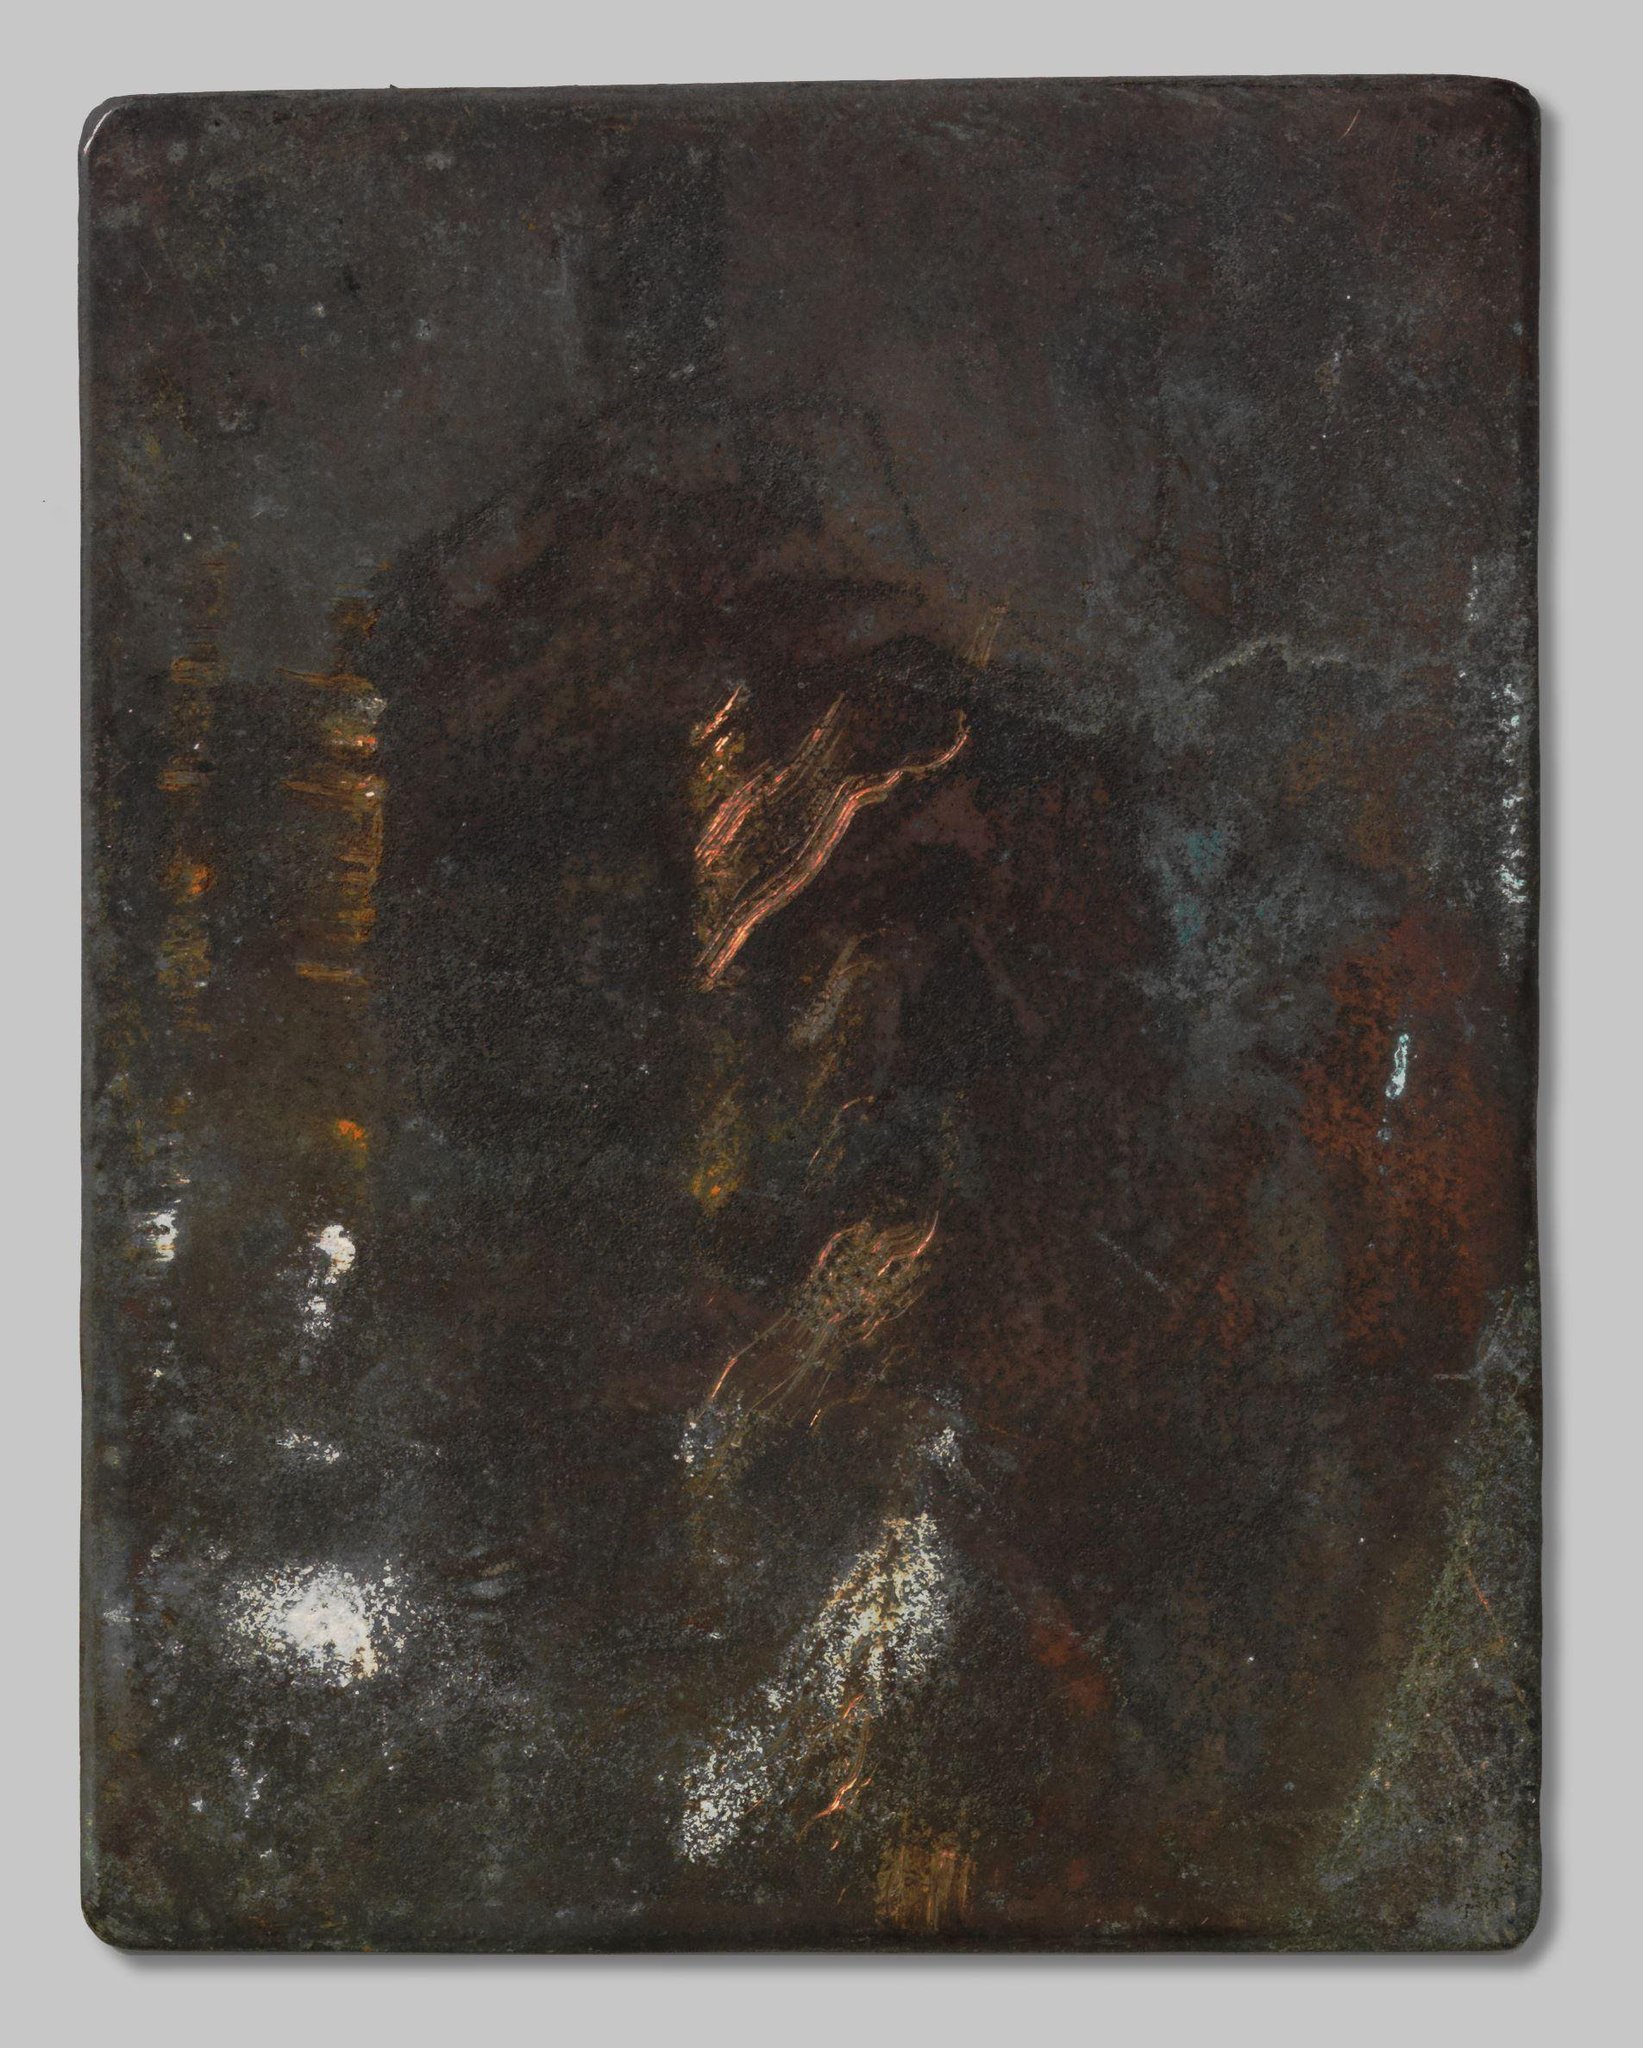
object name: copper plate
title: Boerenjongen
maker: willem witsen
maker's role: draughtsman, painter, print maker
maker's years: 1860-1923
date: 1870-1923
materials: copper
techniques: soft ground etching